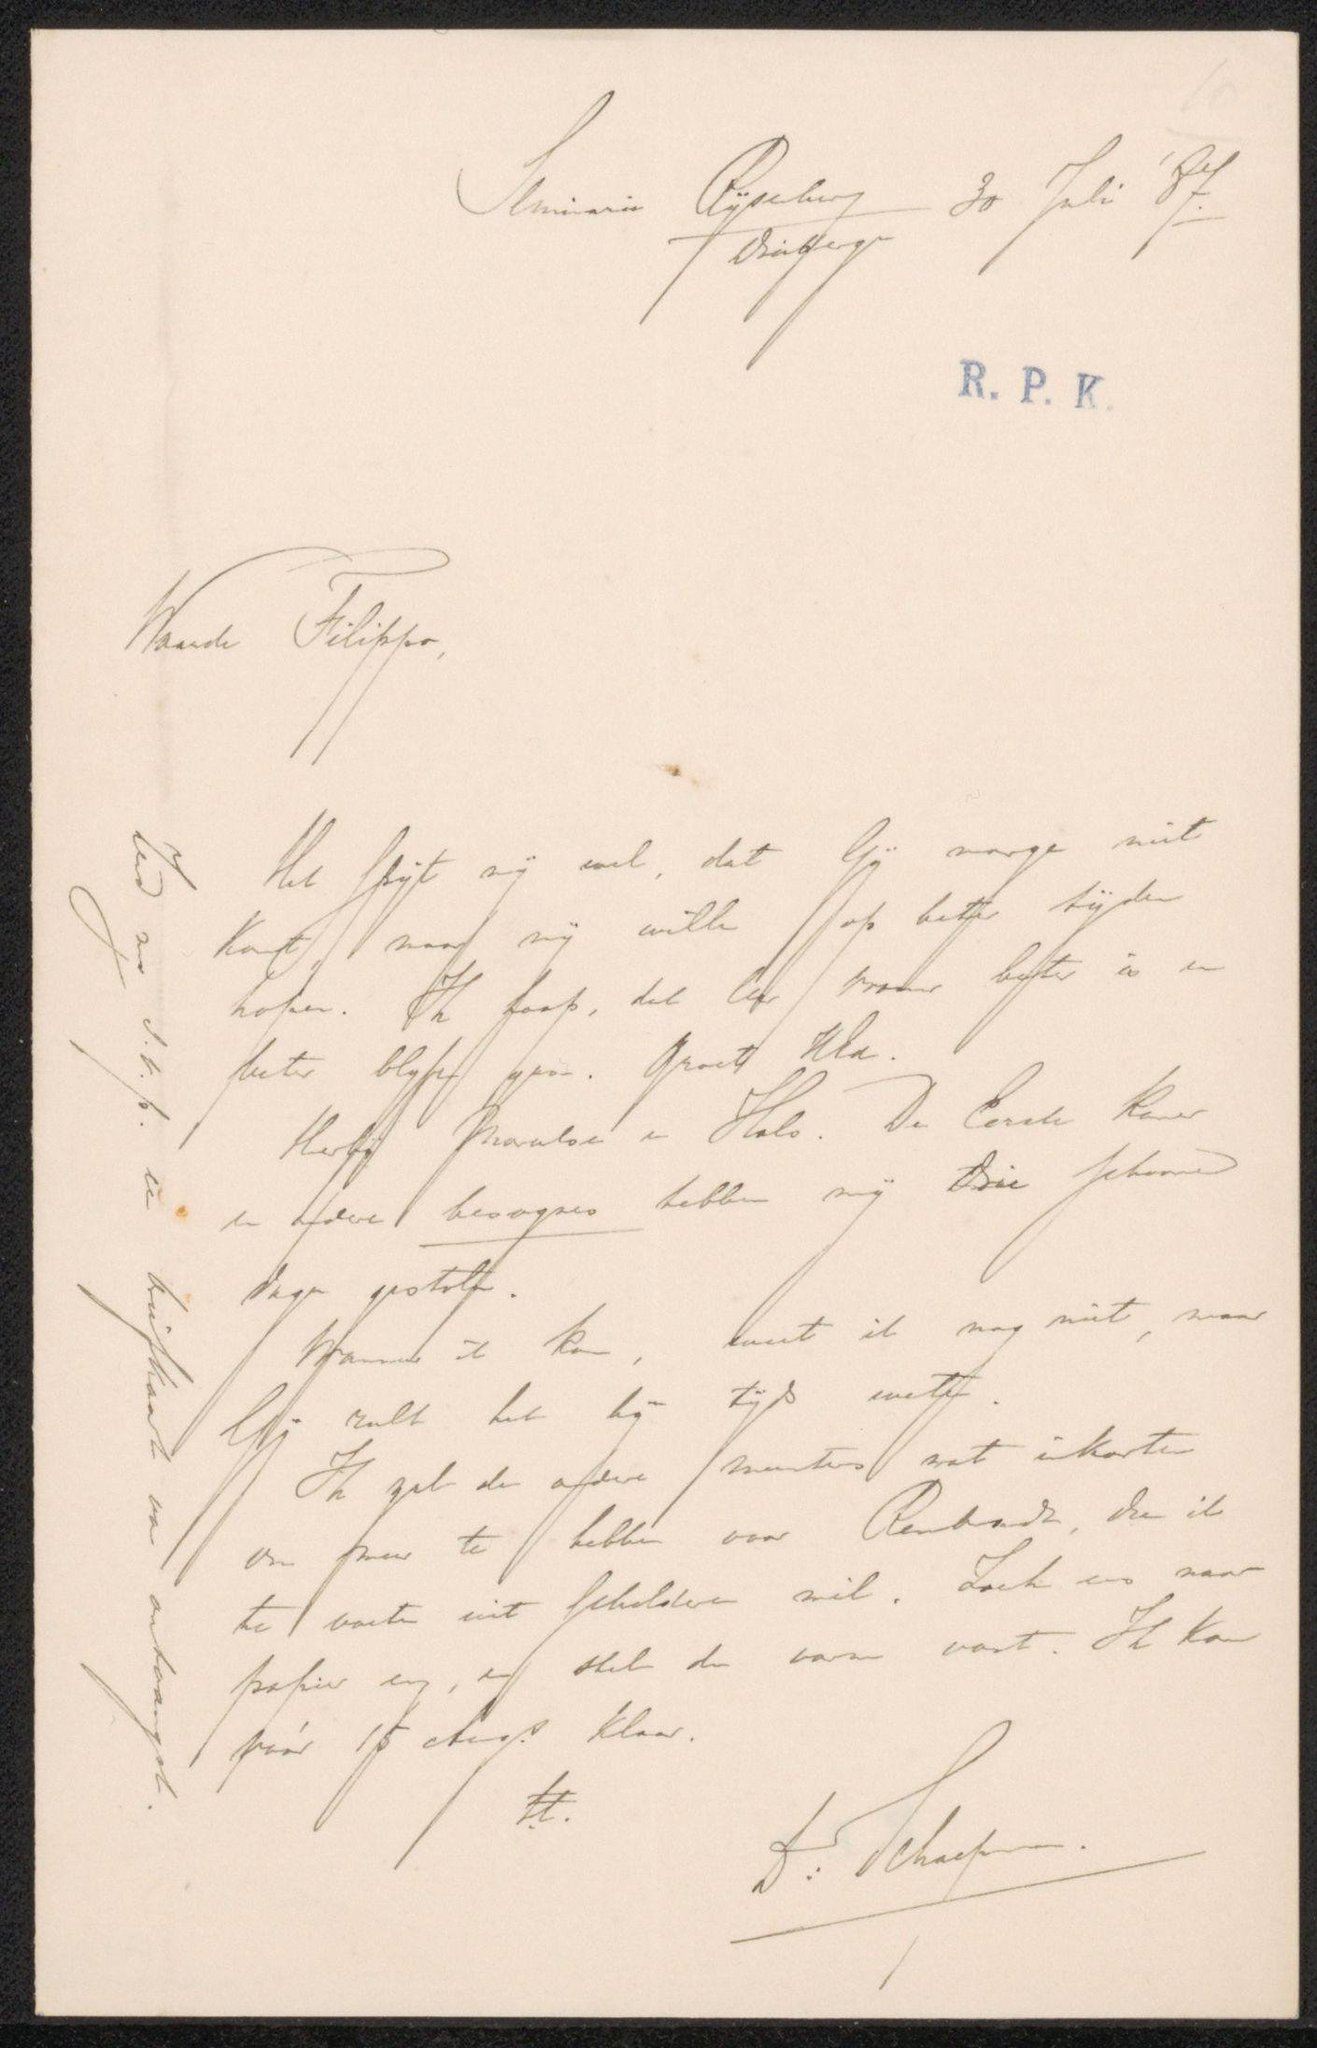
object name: letter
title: Brief aan Filippo Tessaro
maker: herman johannes aloysius maria schaepman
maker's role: priest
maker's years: 1844-1903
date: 1887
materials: ink, paper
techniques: pen, writing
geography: driebergen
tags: antwerp, haarlem, frans hals, leiden, amsterdam, painter, print maker, draughtsman, rembrandt van rijn, printed matter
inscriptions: watermark, collector's mark: Lugt 2233